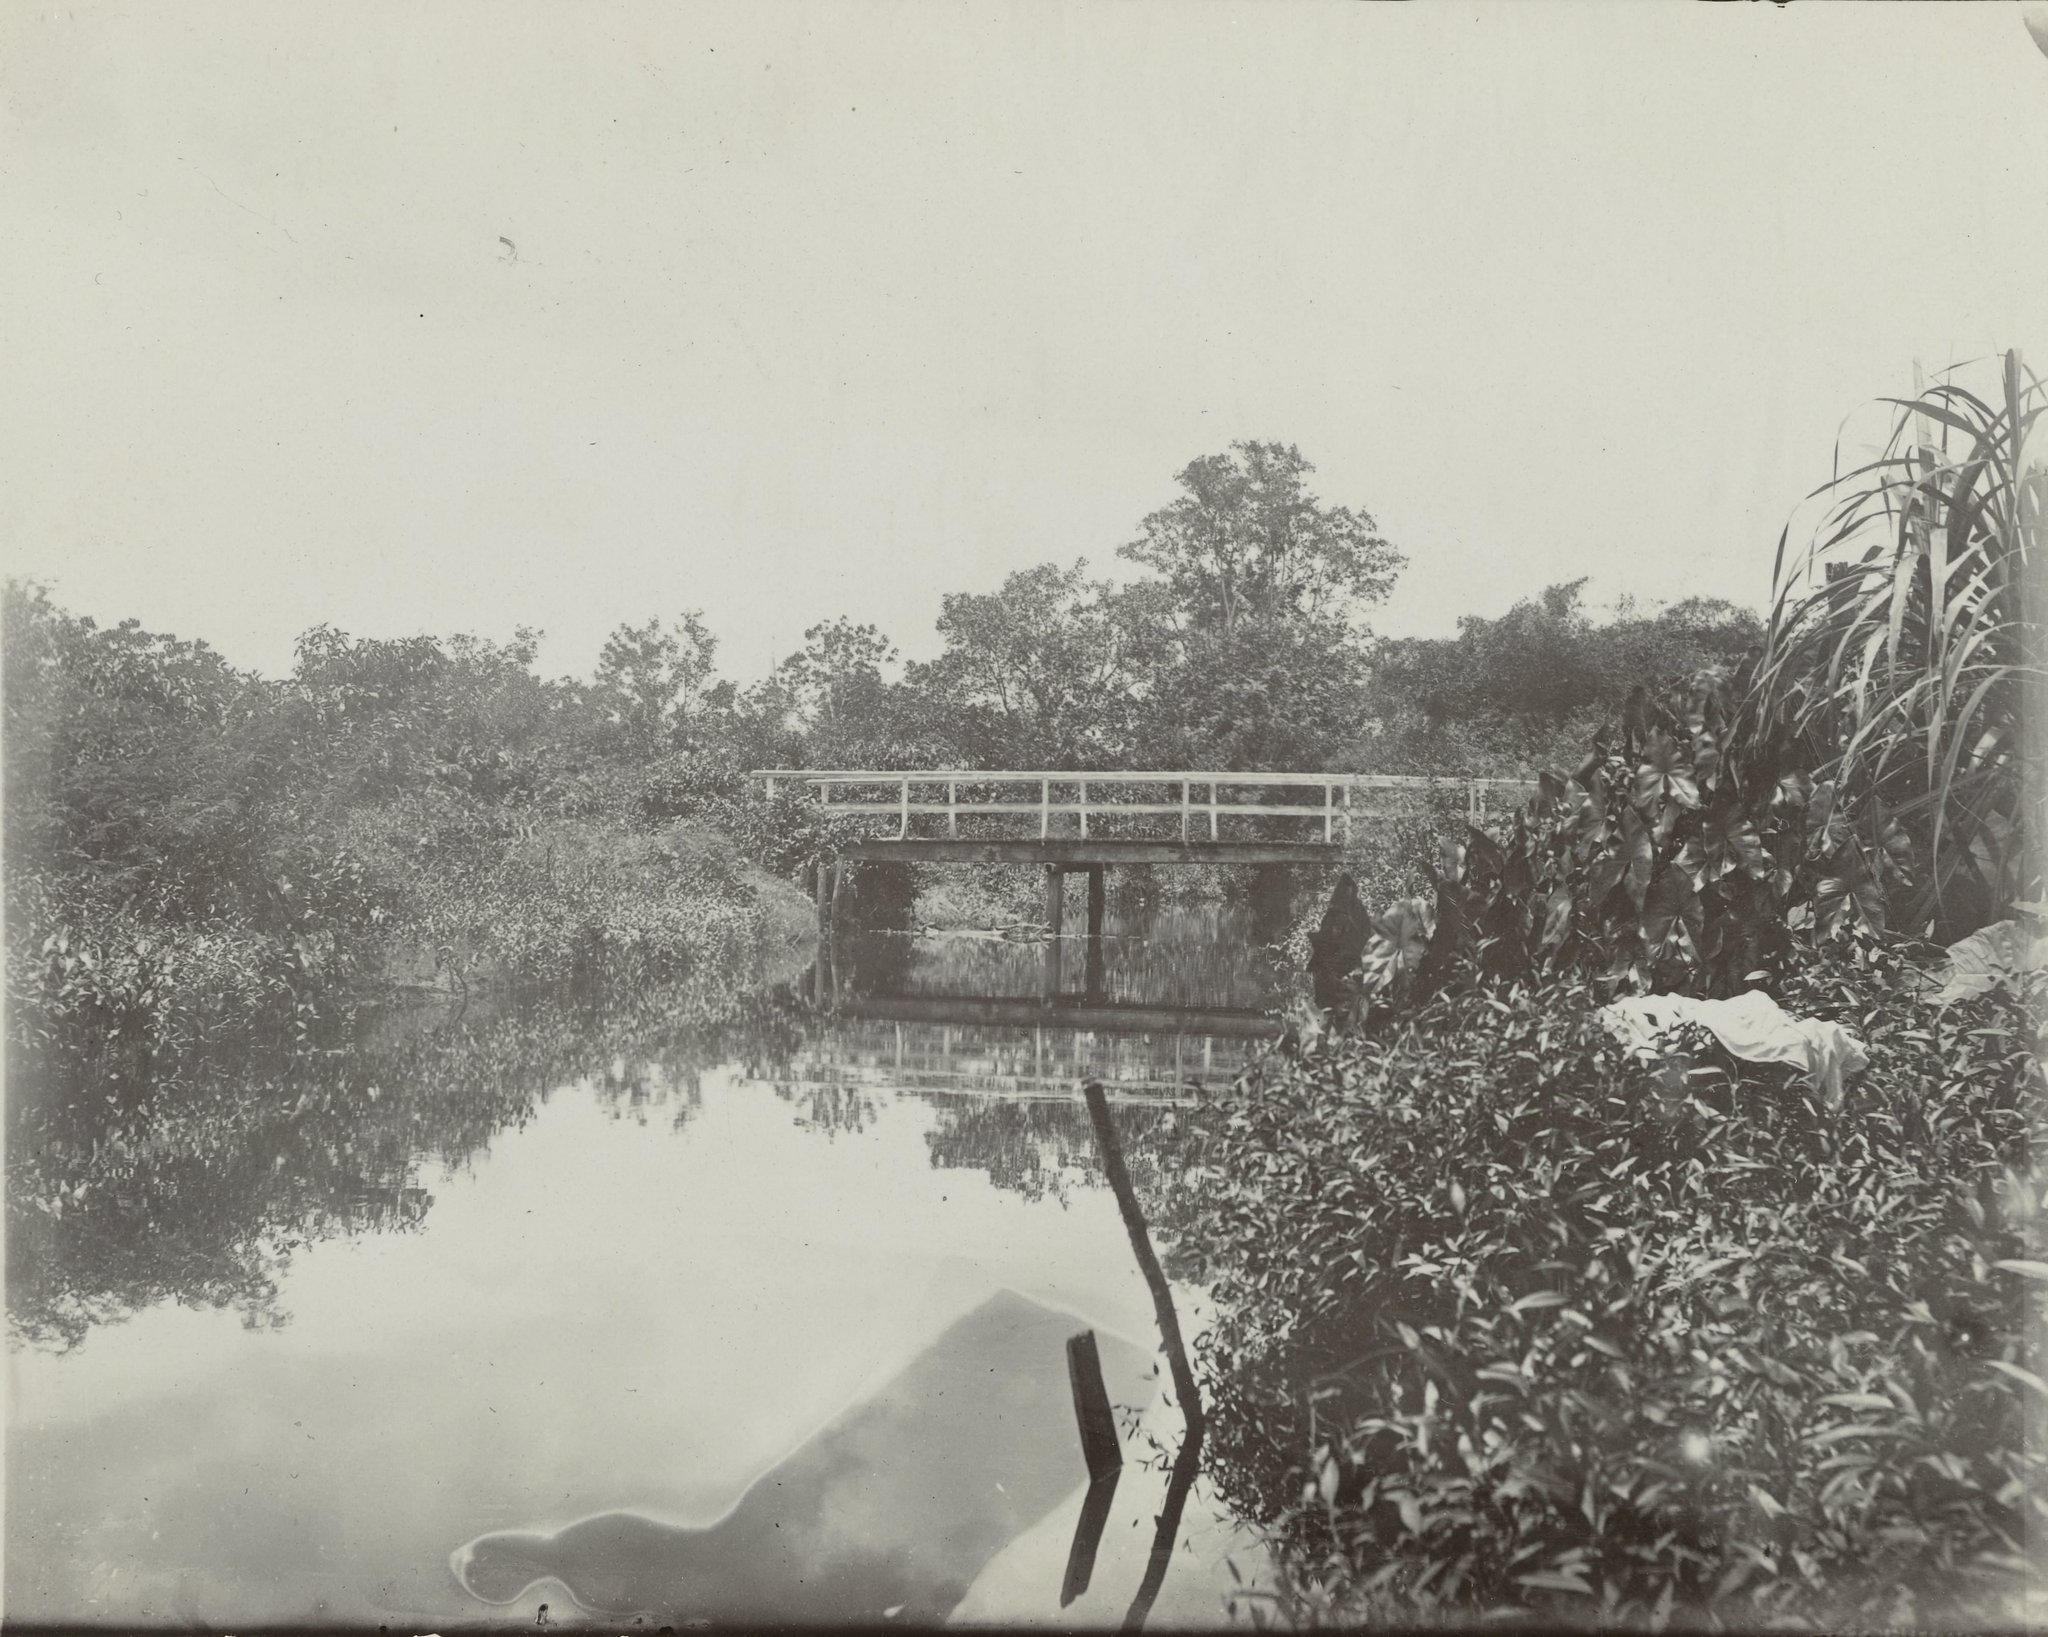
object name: photograph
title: Brug bij de Gonggrijpstraat in Paramaribo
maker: Anonymous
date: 1903-1940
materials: photographic support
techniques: photography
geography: paramaribo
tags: canals, waters (in city) - ii - ideal city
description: Brug over een kanaal bij de Gonggrijpstraat in Paramaribo.